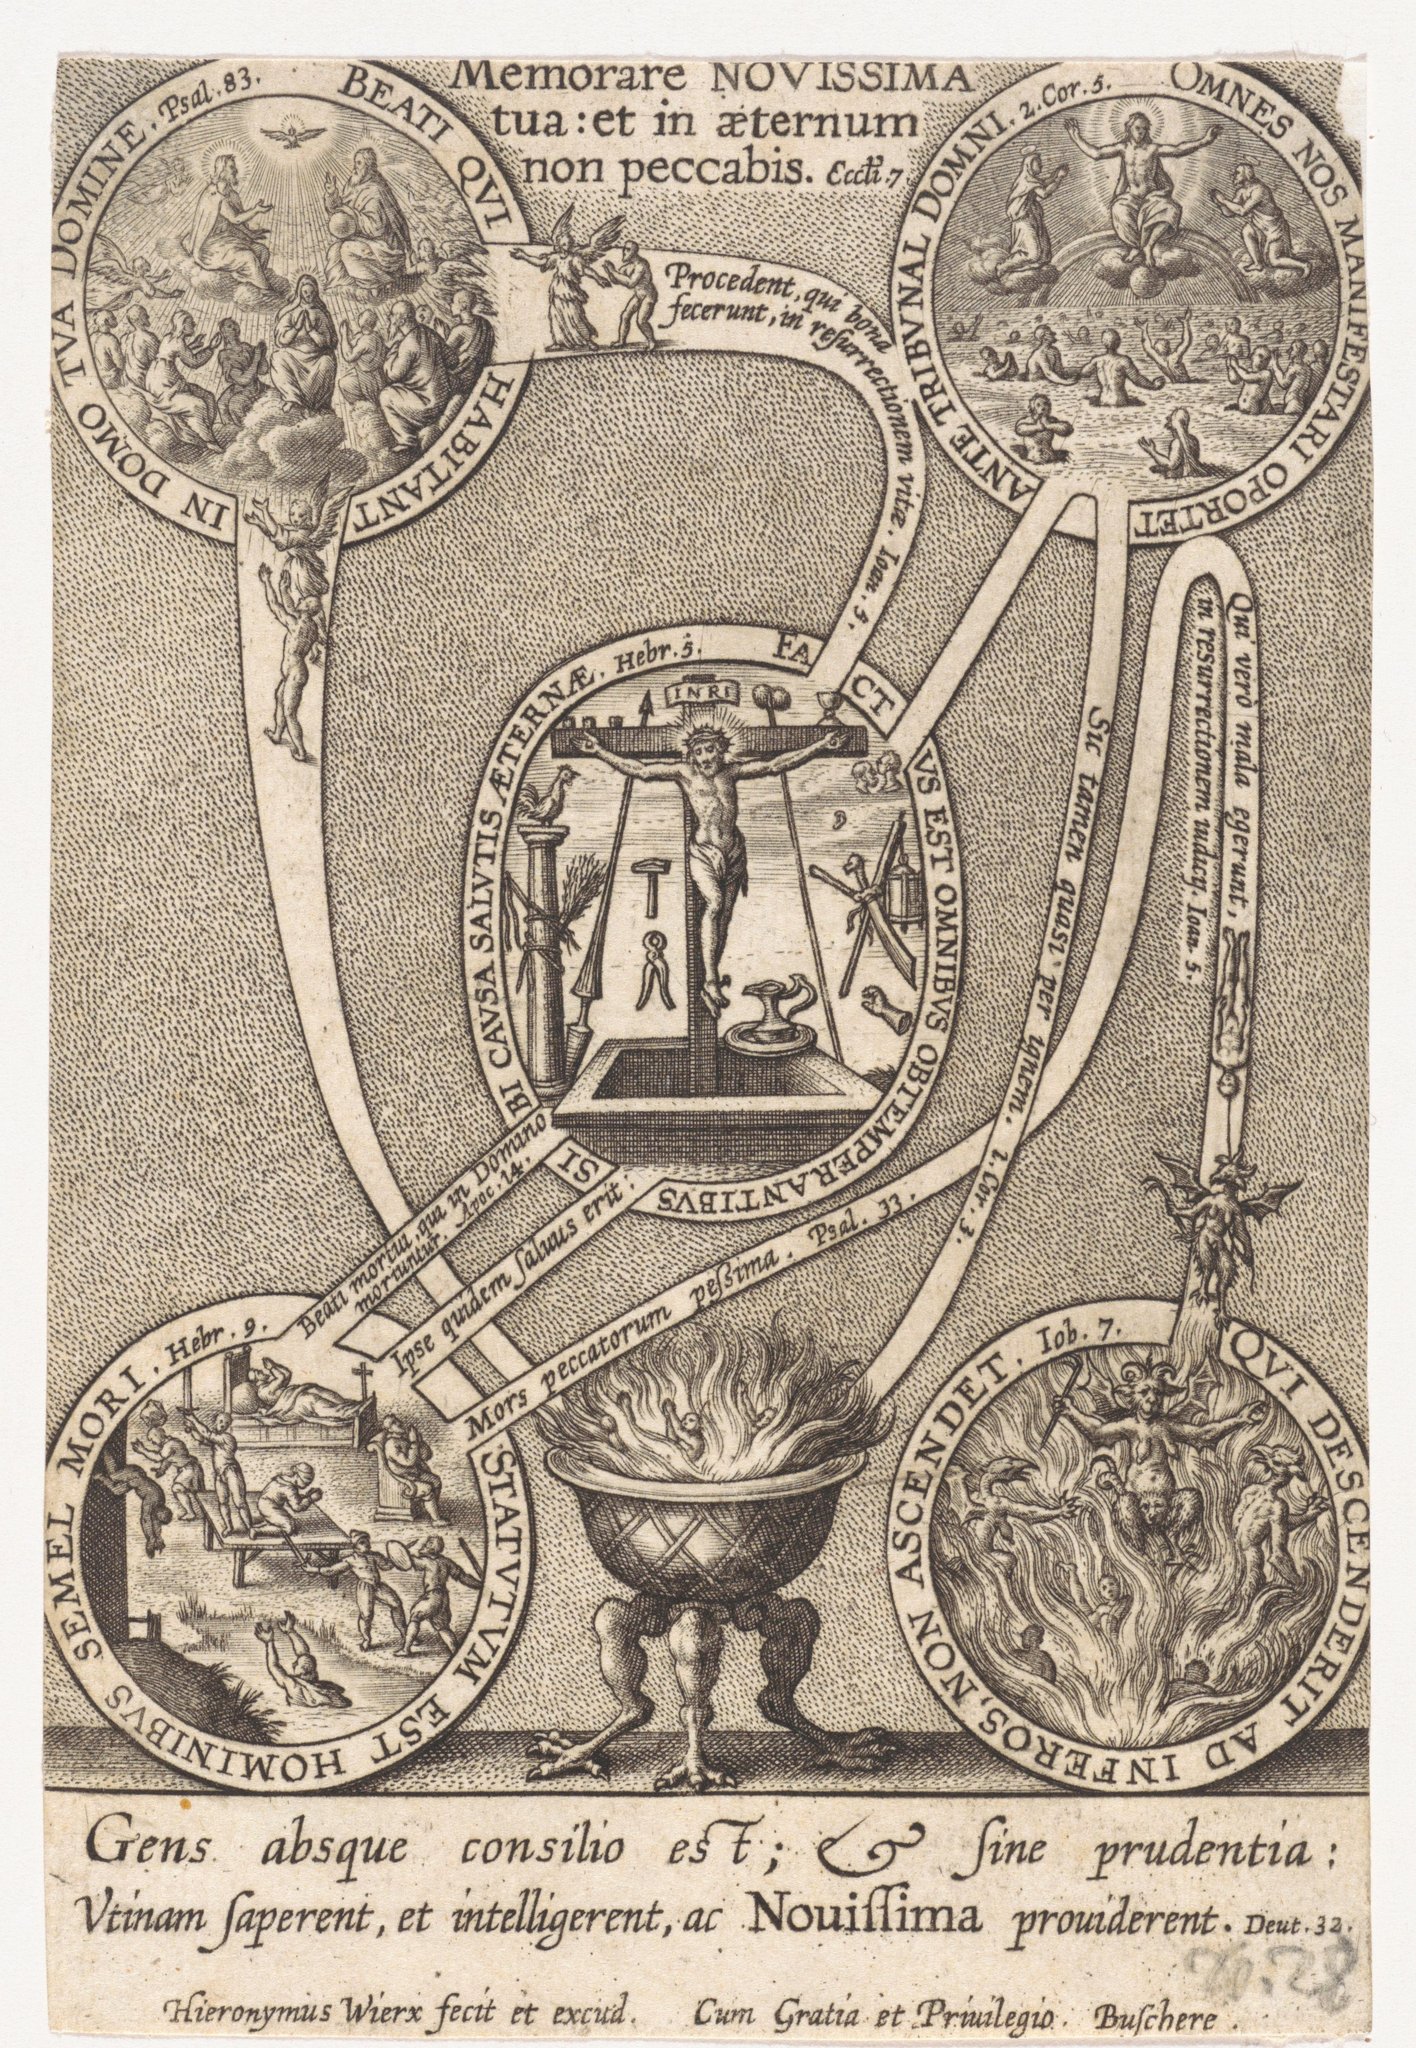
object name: print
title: Allegorie op de verlossing van de mensheid (de vier uitersten van de mens)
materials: paper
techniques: engraving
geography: antwerp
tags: comprehensive representation of last judgement: christ (with sword and lily), often surrounded by elders and sometimes accompanied by mary and john the baptist, appears in the sky with trumpeting angels (and sometimes angels holding the instruments of the passion); after the resurrection of the dead the blessed are led to heaven by angels, and the damned are dragged into hell by devils (+ variant), the soul travelling, hell and purgatory, the four last things, journey to heaven, pathway to heaven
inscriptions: collector's mark: Lugt 2228, inscription: ‘Memorare novissima tua, et in aeternum non peccabis. Eccl. 7’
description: Vijf medaillons met scènes van de vier uitersten - dood, oordeel, hemel en hel - verbonden door banden met tekst. De banden vormen verschillende routes die de ziel kan afleggen. De dood (linksonder) leidt naar het Laatste Oordeel (rechtsboven), de hel (rechtsonder) of de hemel (linksboven). De gekruisigde Christus (midden) verbindt de uitersten. De ziel kan kiezen tussen de korte route, of de lange route die via het vagevuur (midden onder) loopt. In de marge een tweeregelig Bijbelcitaat uit Deut. 32 in het Latijn.